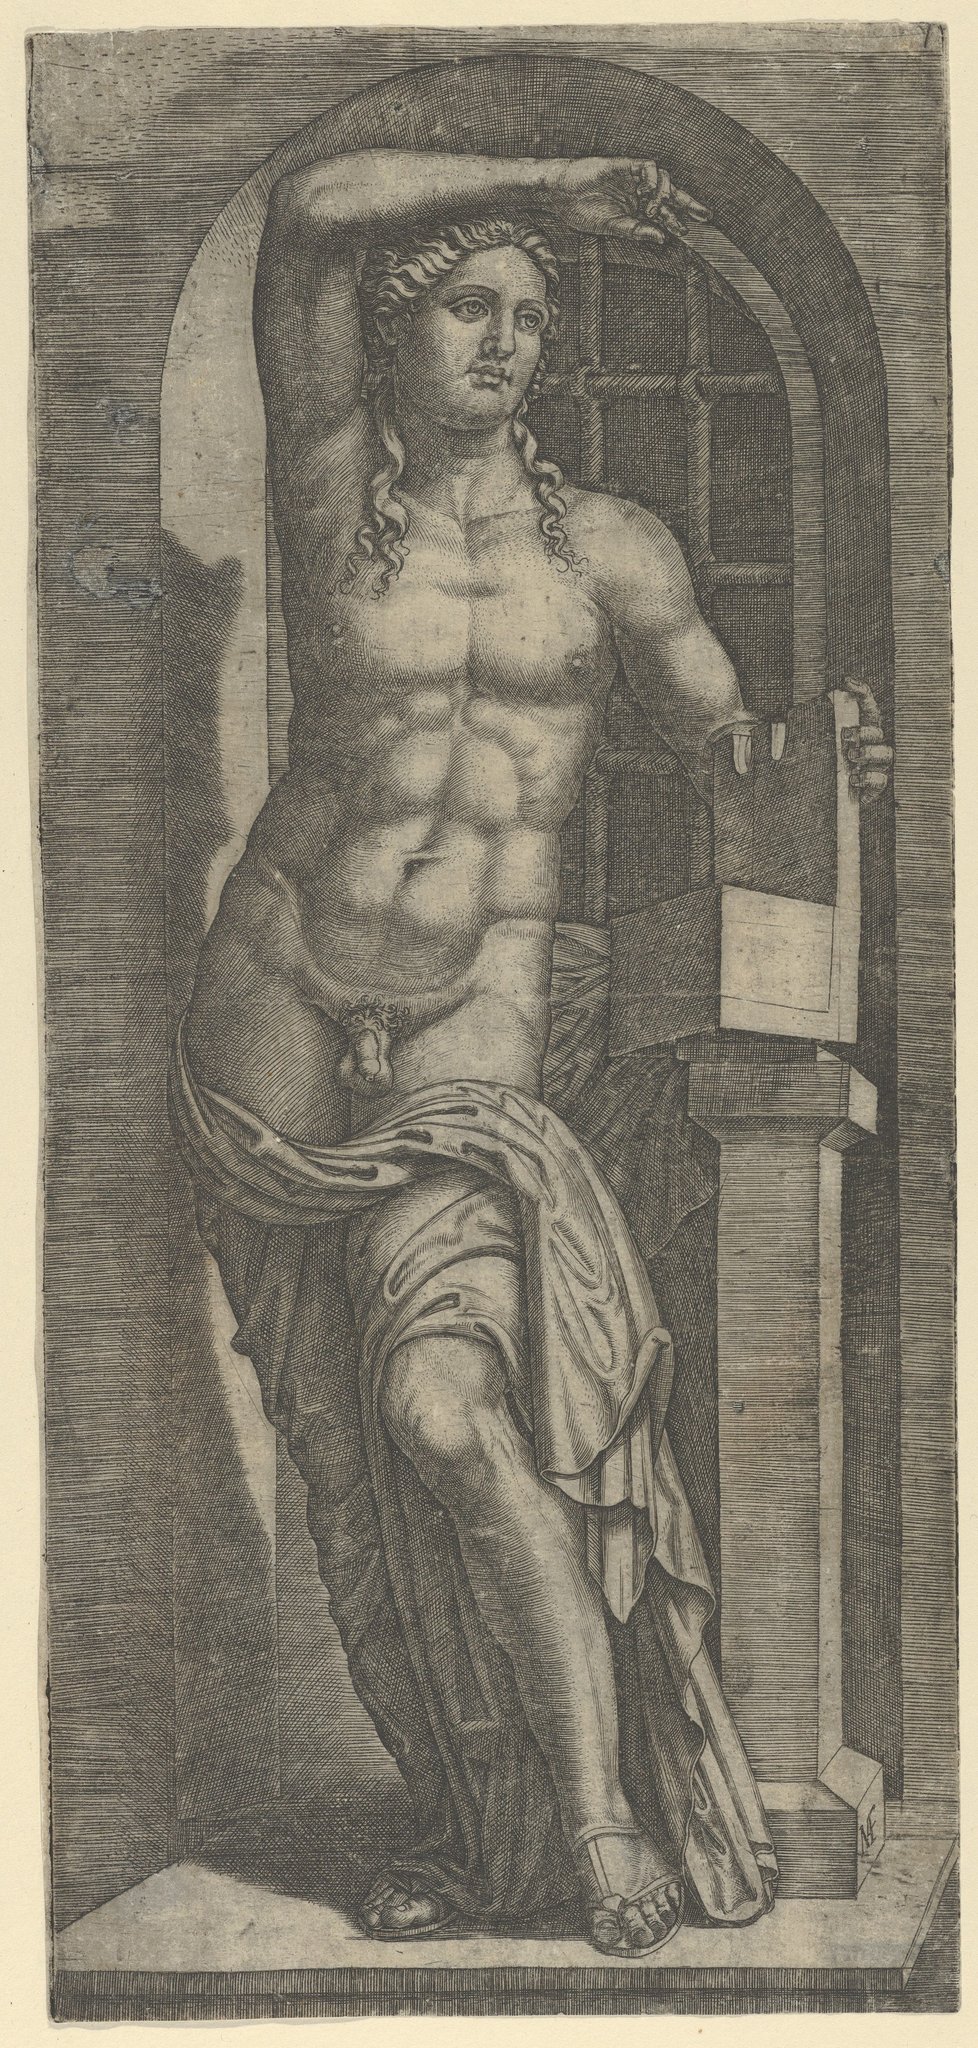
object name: print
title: Apollo partly naked standing in a niche, left hand resting on an open box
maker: marcantonio raimondi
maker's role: artist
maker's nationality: italian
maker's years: 1475-1534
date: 1500-1527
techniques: engraving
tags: male nudes,apollo